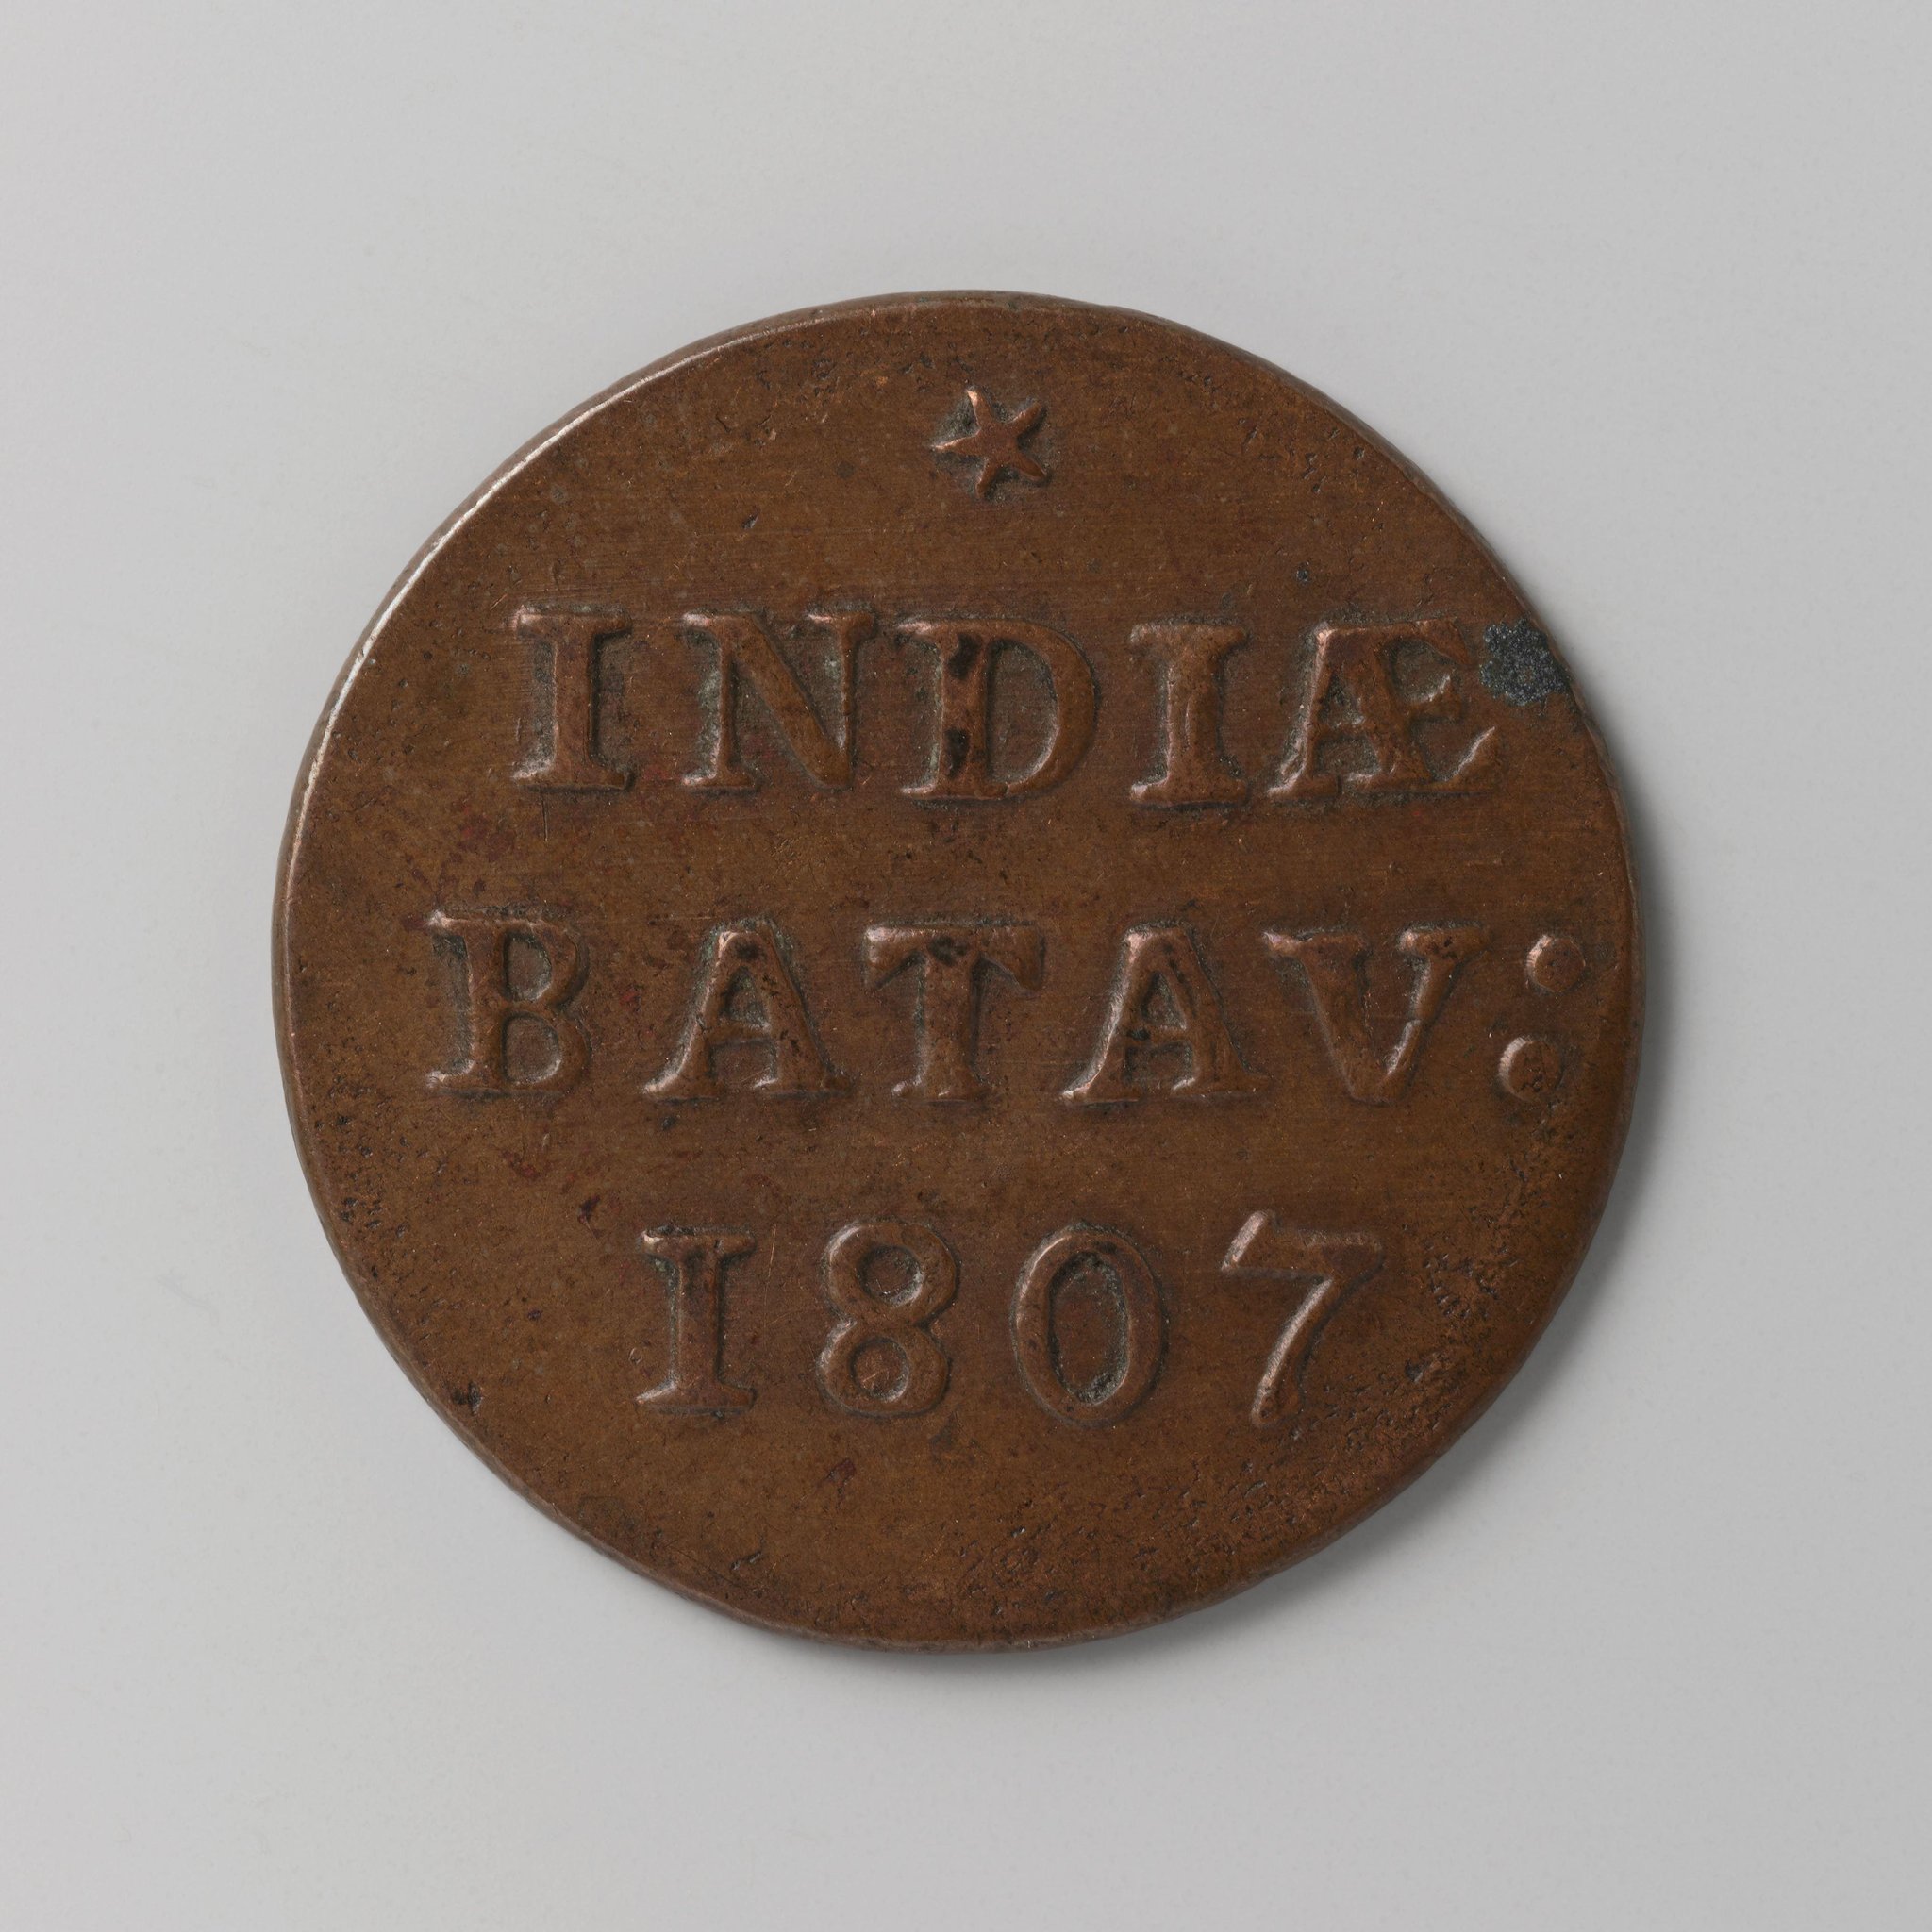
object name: duit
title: Duit voor Nederlands Indië uit Holland,1807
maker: louis napoleon (king of holland)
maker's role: koning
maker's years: 1778-1846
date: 1807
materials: copper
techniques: striking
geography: hoorn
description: Koperen munt. Voorzijde: tweeregelig opschrift, waarboven muntteken ster en waaronder jaartal. Keerzijde: tussen waarde-aanduiding 5 1/16 G gekroond generaliteitswapenschild. Gladde rand.